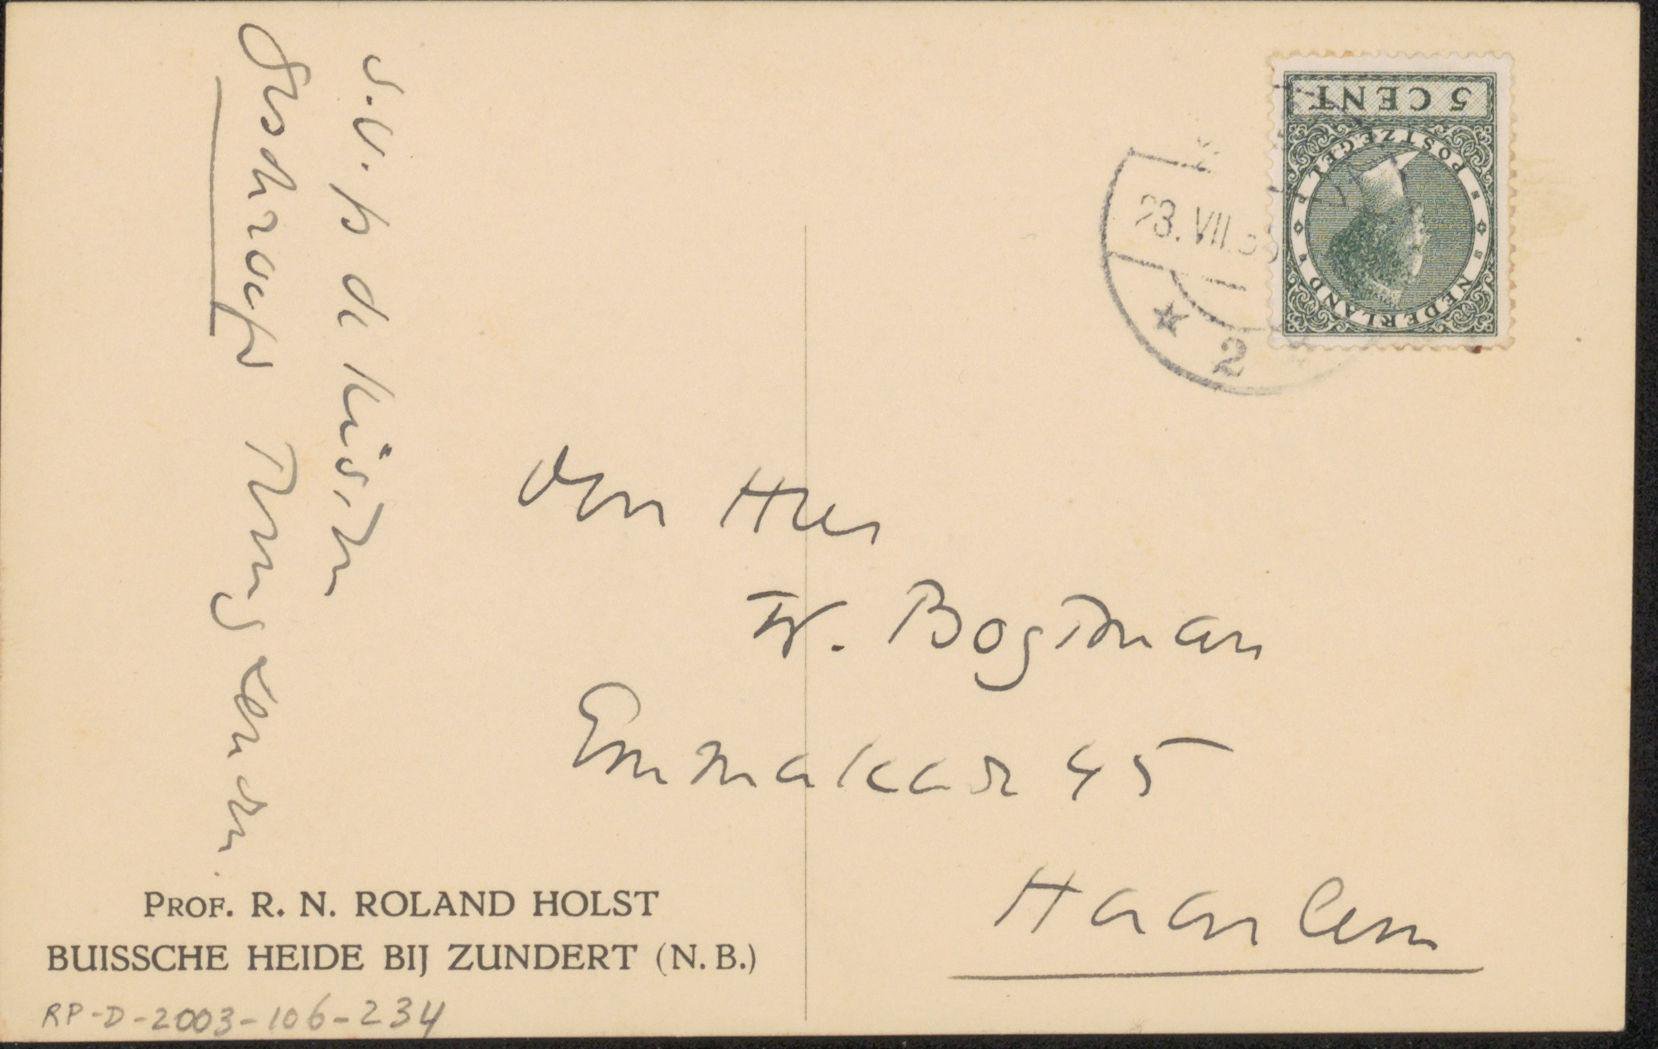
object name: postcard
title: Briefkaart aan Willem Bogtman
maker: richard nicolaüs roland holst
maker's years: 1868-1938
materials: cardboard, ink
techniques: pen, printing, writing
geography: buissche heide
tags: haarlem, willem bogtman, applied arts, arts and crafts; industrial design, painting (including book-illumination, miniature-painting)